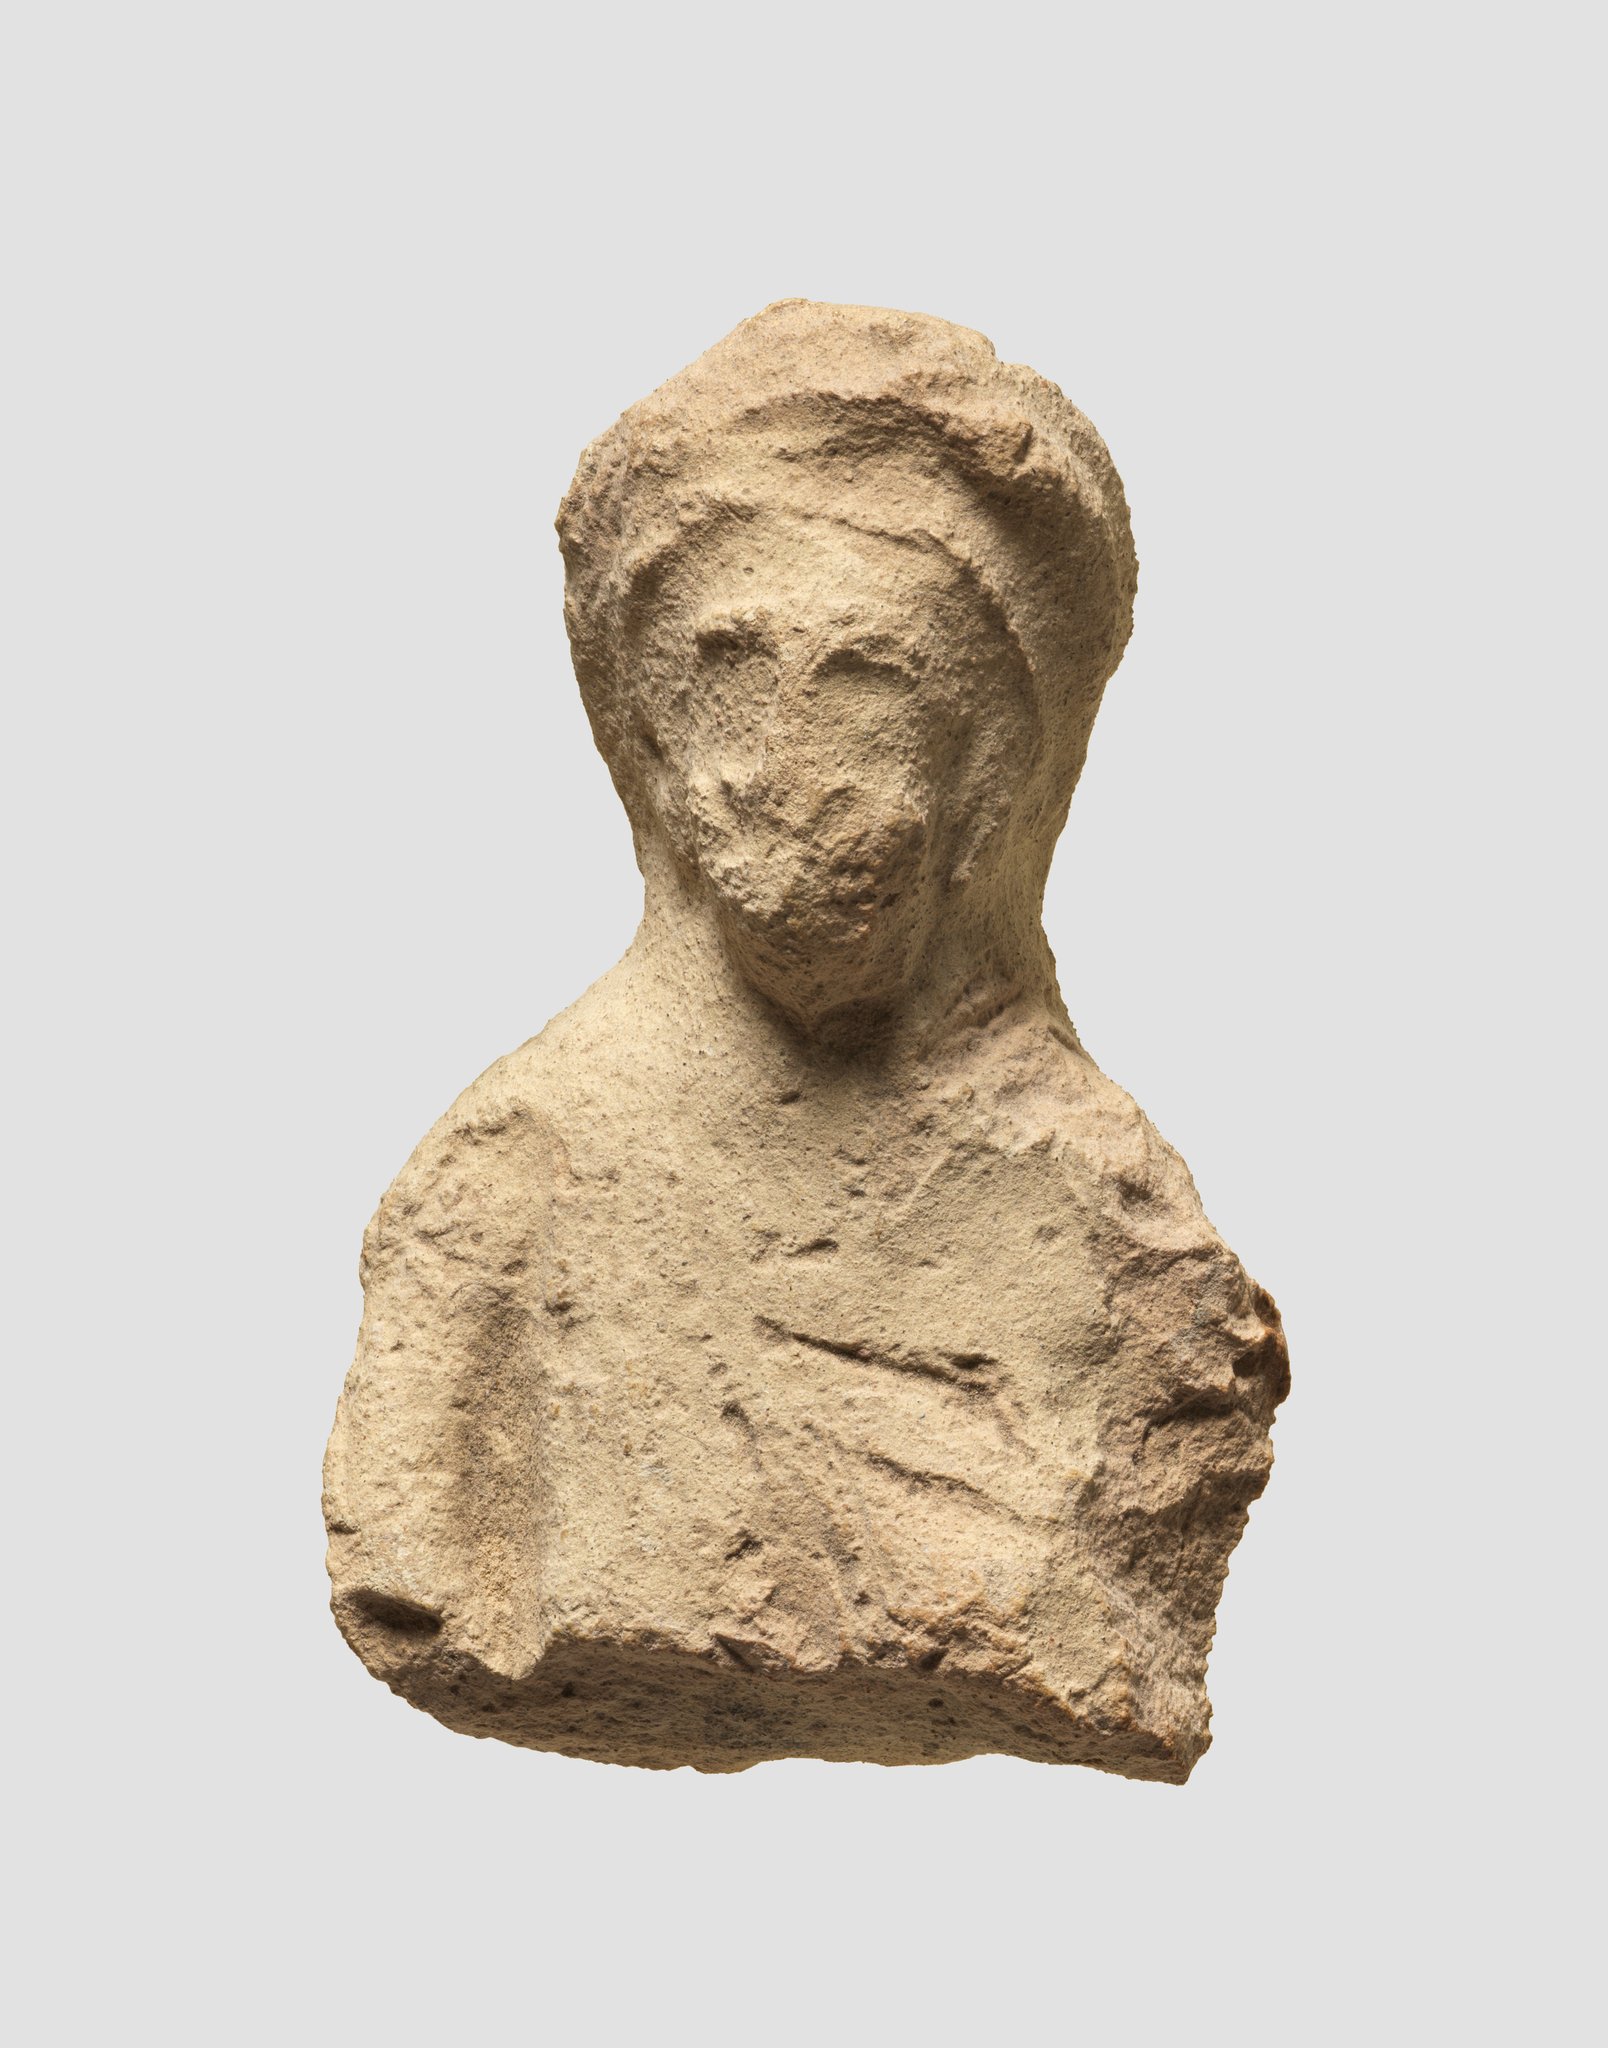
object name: sculpture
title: Figure fragment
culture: parthian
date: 101-200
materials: ceramic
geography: mesopotamia